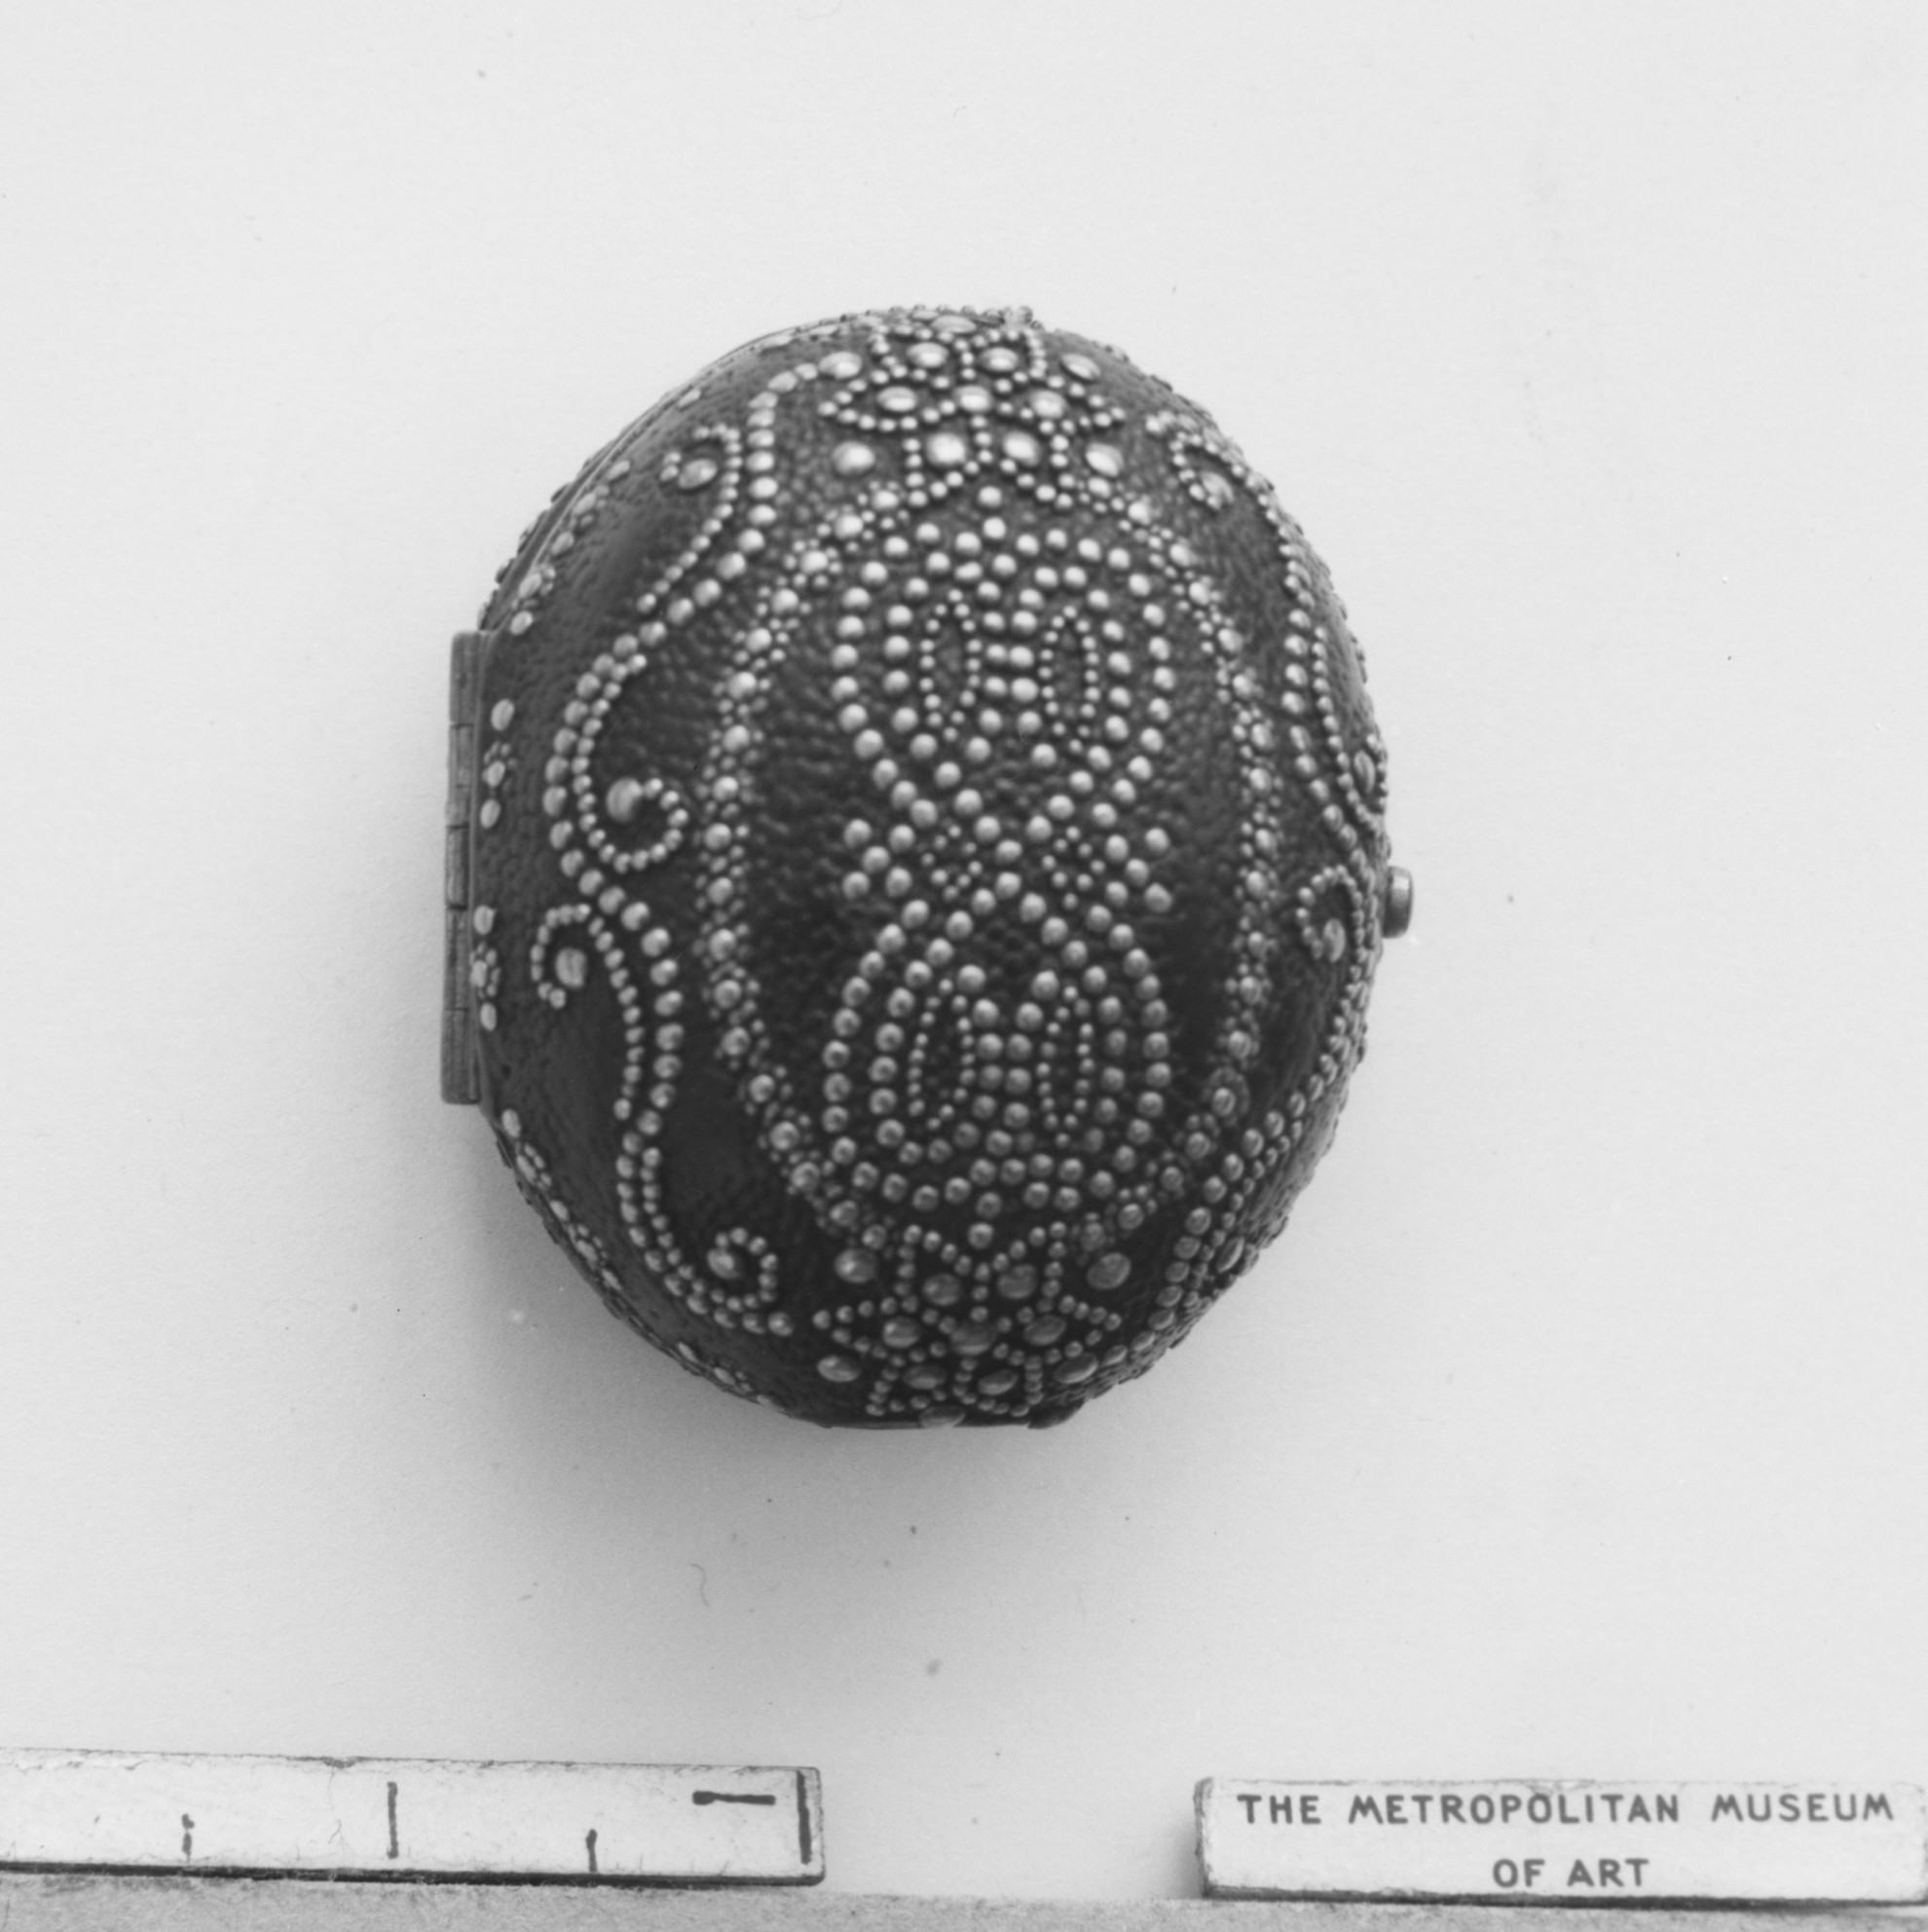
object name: watch case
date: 1650-1680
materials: gold, leather